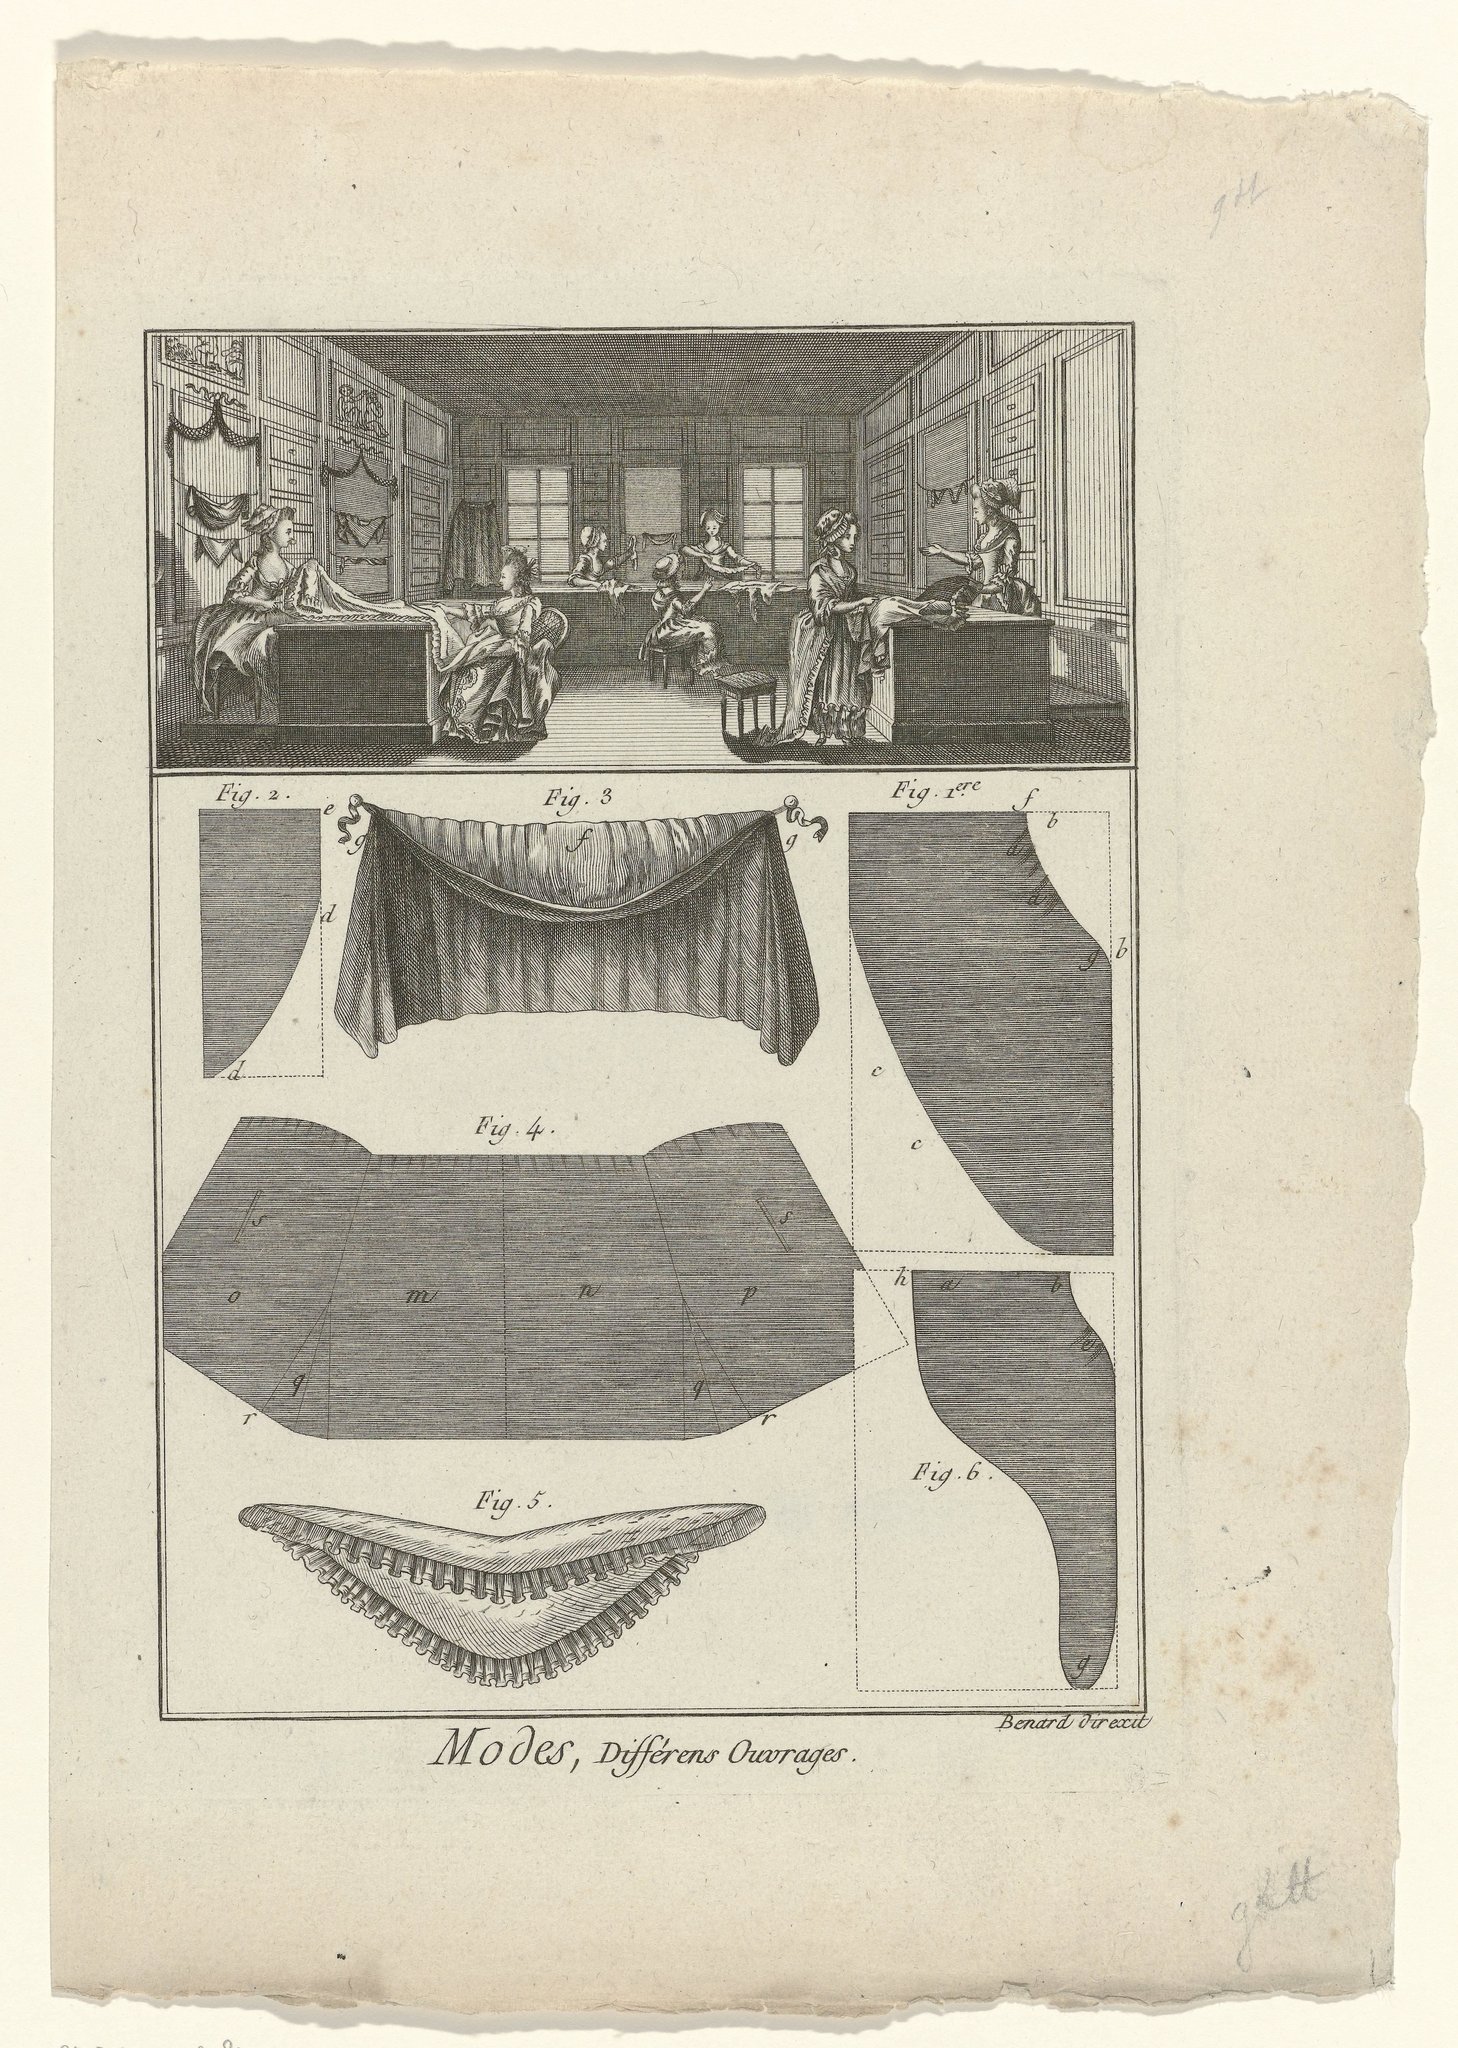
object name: print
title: Modes, Différens Ouvrages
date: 1771-1772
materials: paper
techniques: engraving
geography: paris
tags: shop, store, fashion, clothing (+ home making of clothes), head-gear (+ women's clothes), fashion plates, dress, gown (+ women's clothes), materials ~ textile industry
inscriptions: title: ‘Modes, Différens Ouvrages.’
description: Interieur van een stoffenwinkel met zeven vrouwen, die stof aan het bekijken zijn. Daaronder een set van zes patroondelen. De prent komt uit het boek: Encyclopédie ou dictionnaire raisonné des sciences, des arts et des metiers door M. Diderot en M. d'Alembert, Parijs, 1751-1772.